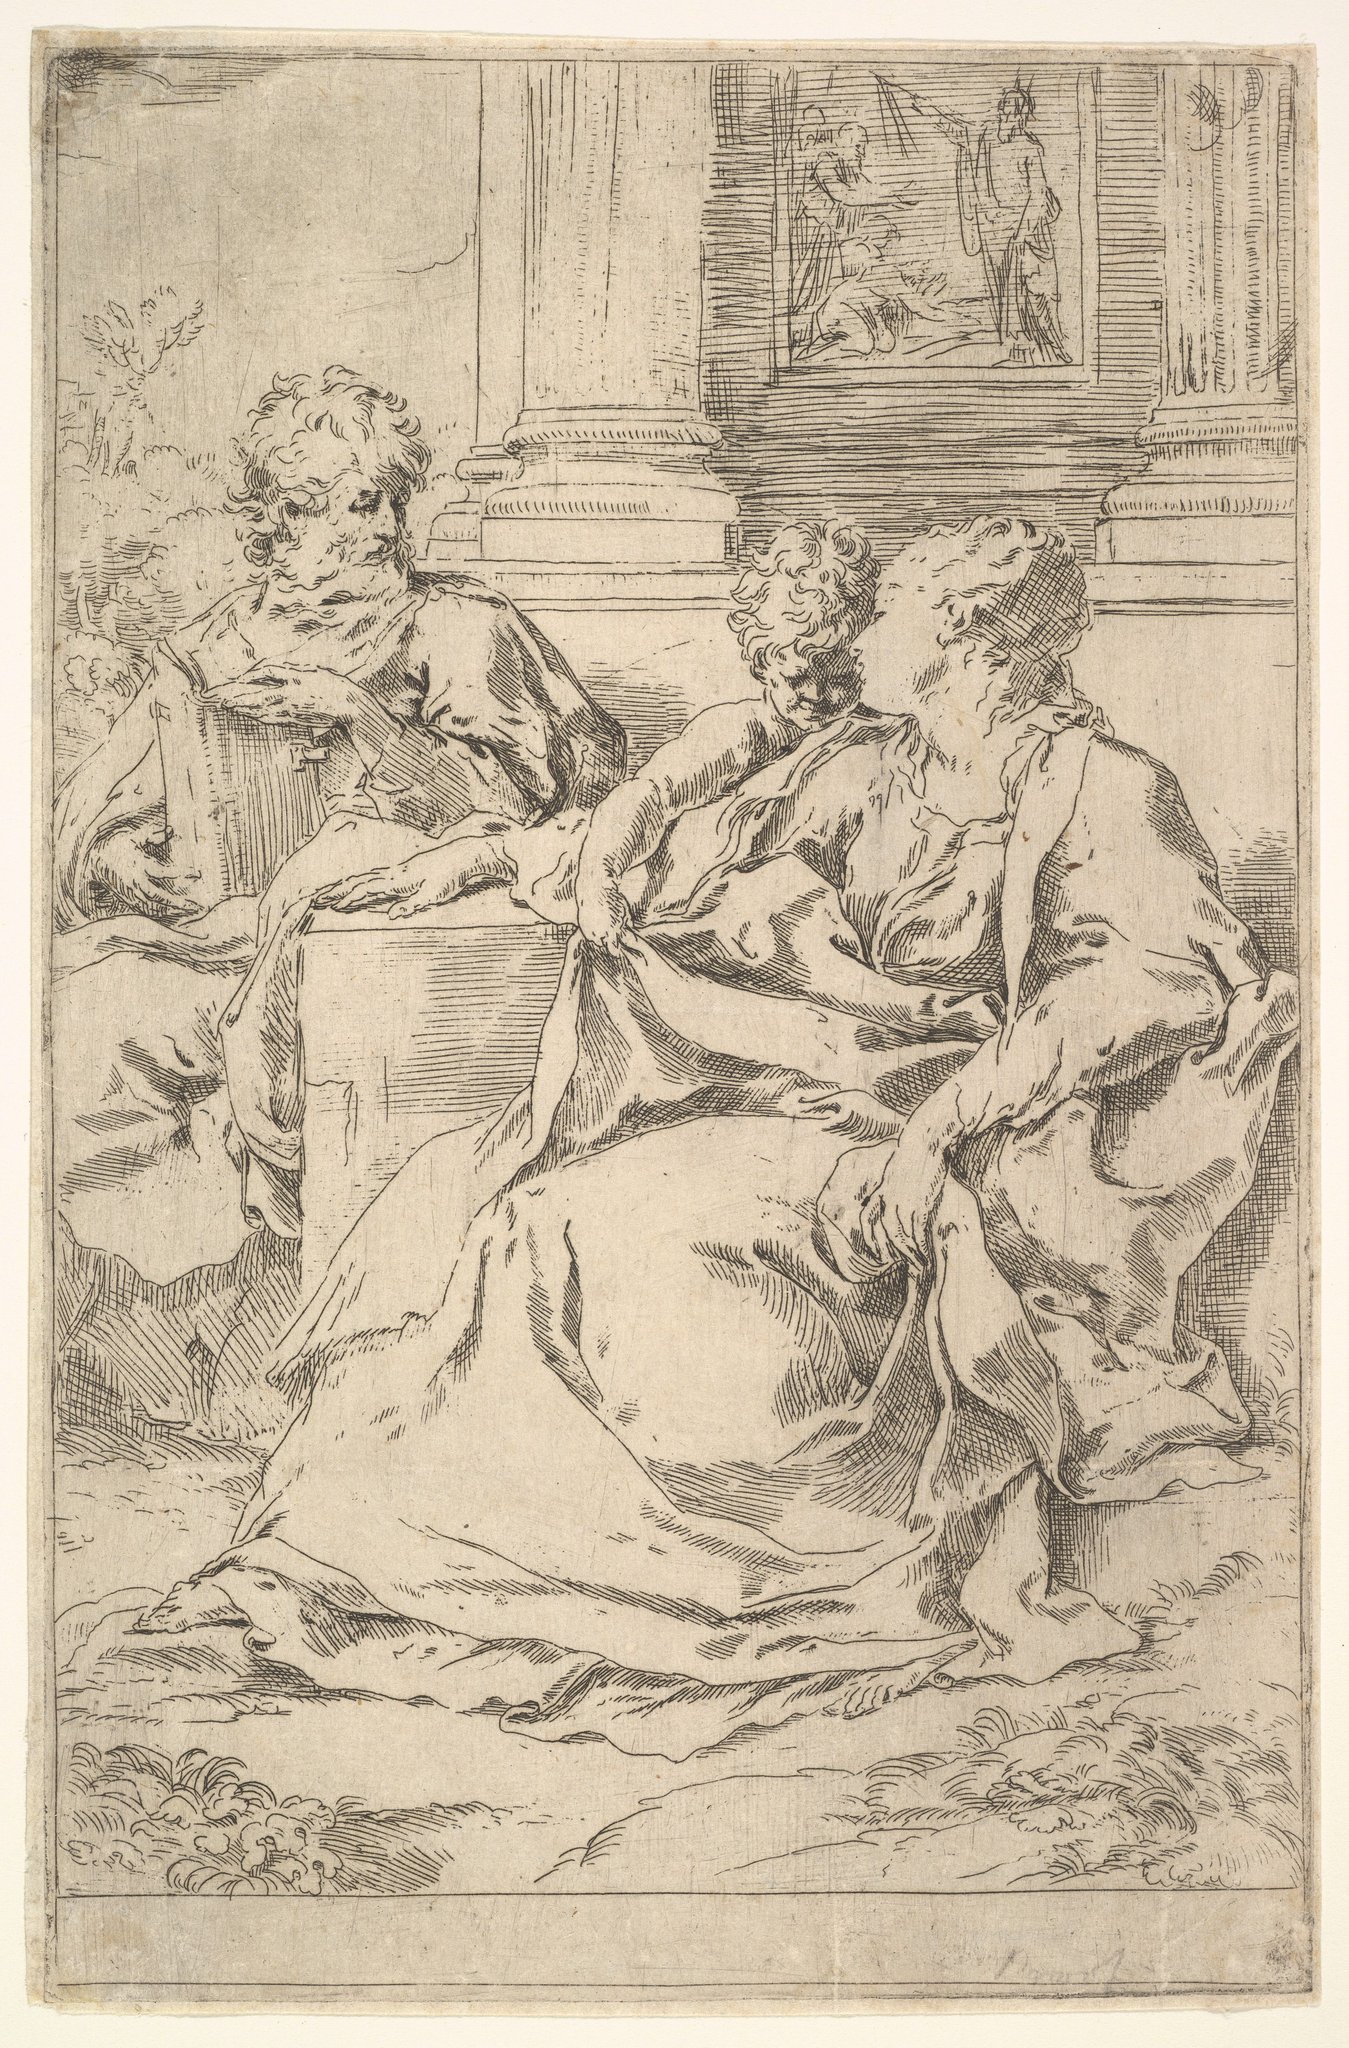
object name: print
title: The Holy Family with Scriptural Scene in Background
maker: guido reni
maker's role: artist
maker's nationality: italian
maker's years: 1575-1642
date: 1575-1642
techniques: etching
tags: holy family